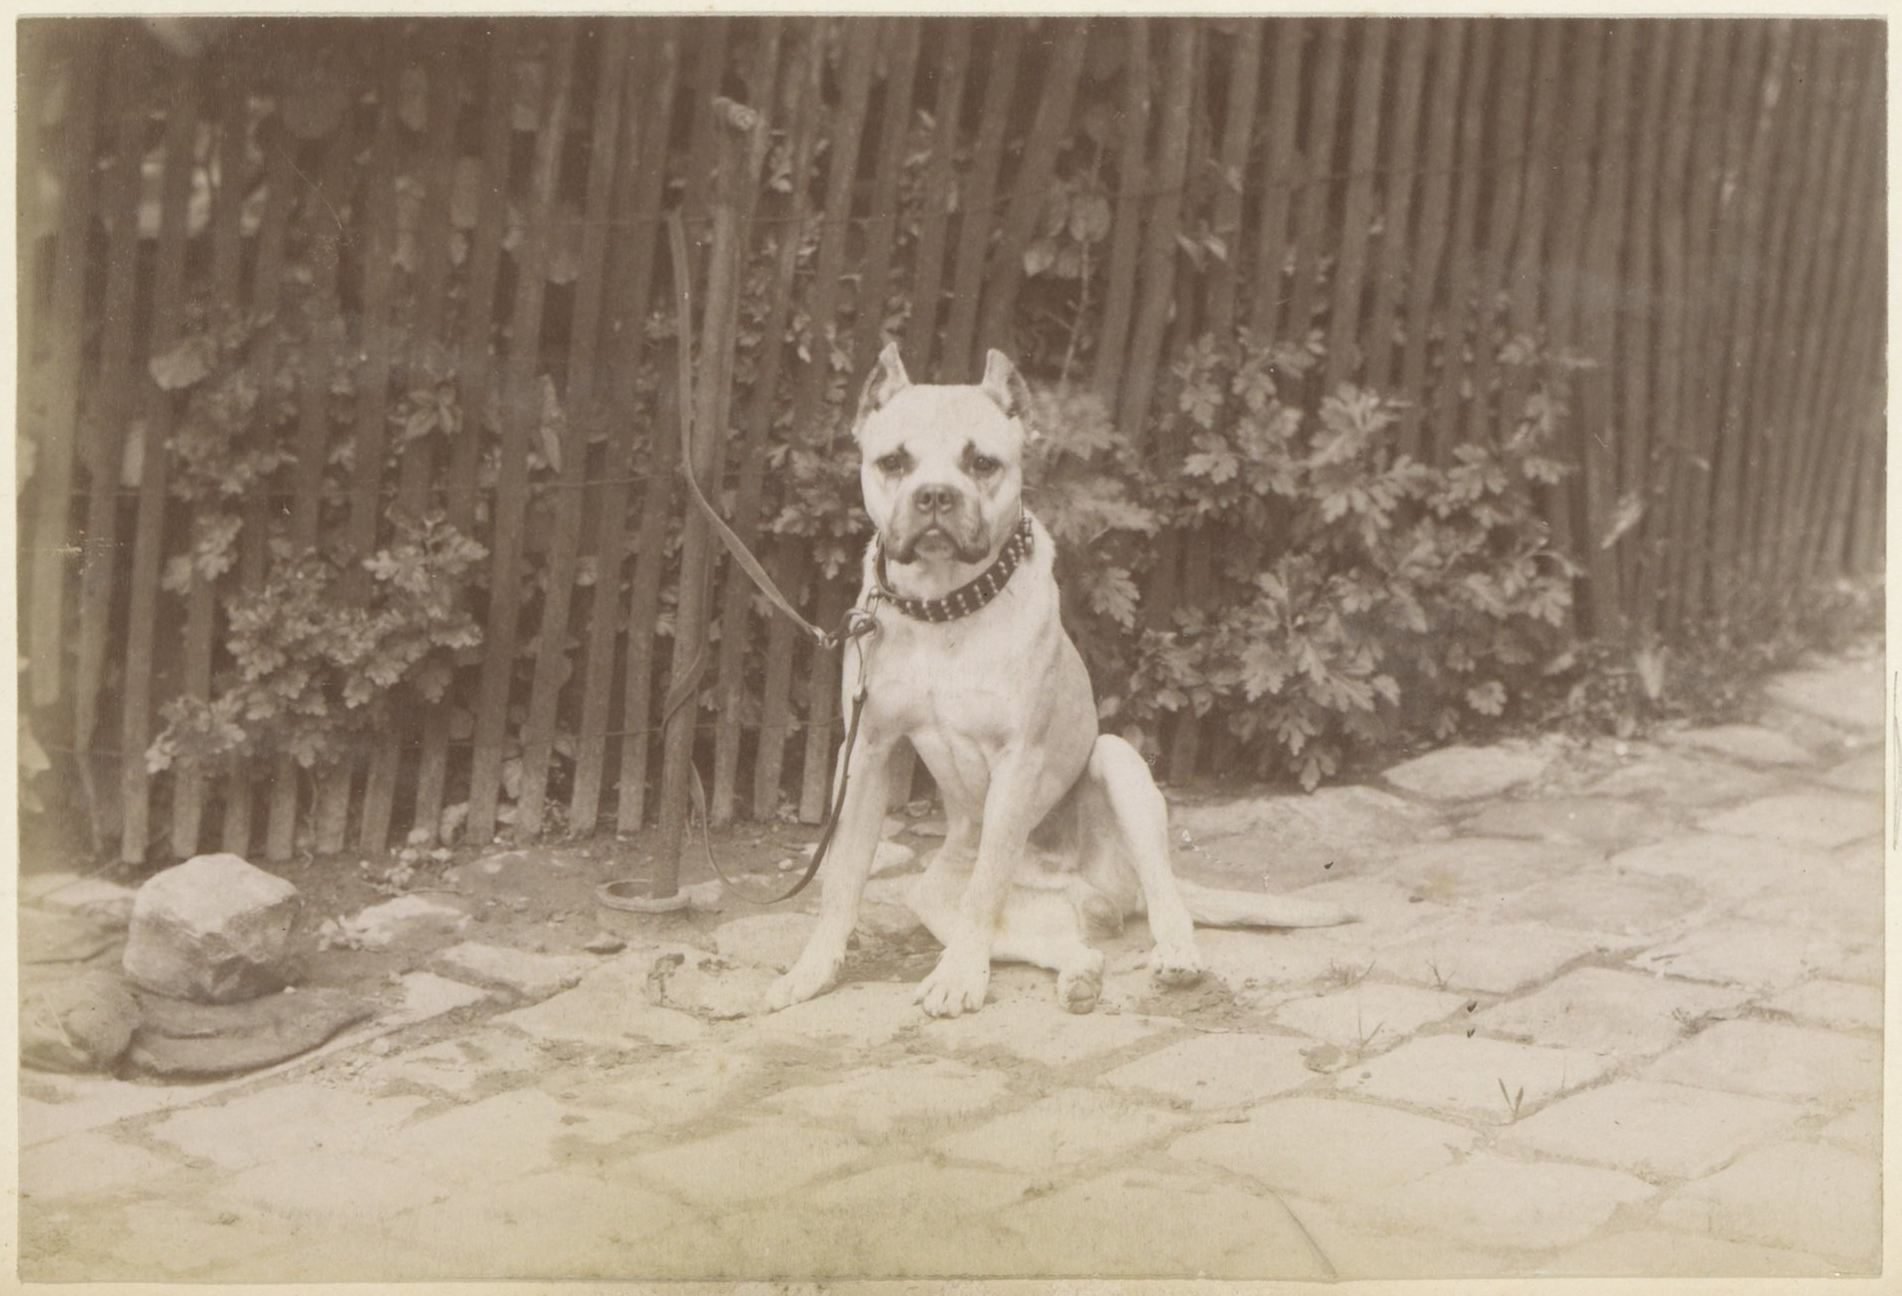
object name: photograph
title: Aangelijnde hond zittend bij een hek in Frankrijk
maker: Anonymous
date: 1900-1910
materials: paper, photographic support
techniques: albumen print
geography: france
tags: fence, wall, paling, dog, france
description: Onderdeel van Fotoalbum van een Franse amateurfotograaf met opnames van een familie, distilleerderij Delizy & Doistau Fils, het leger en bezienswaardigheden in Frankrijk.